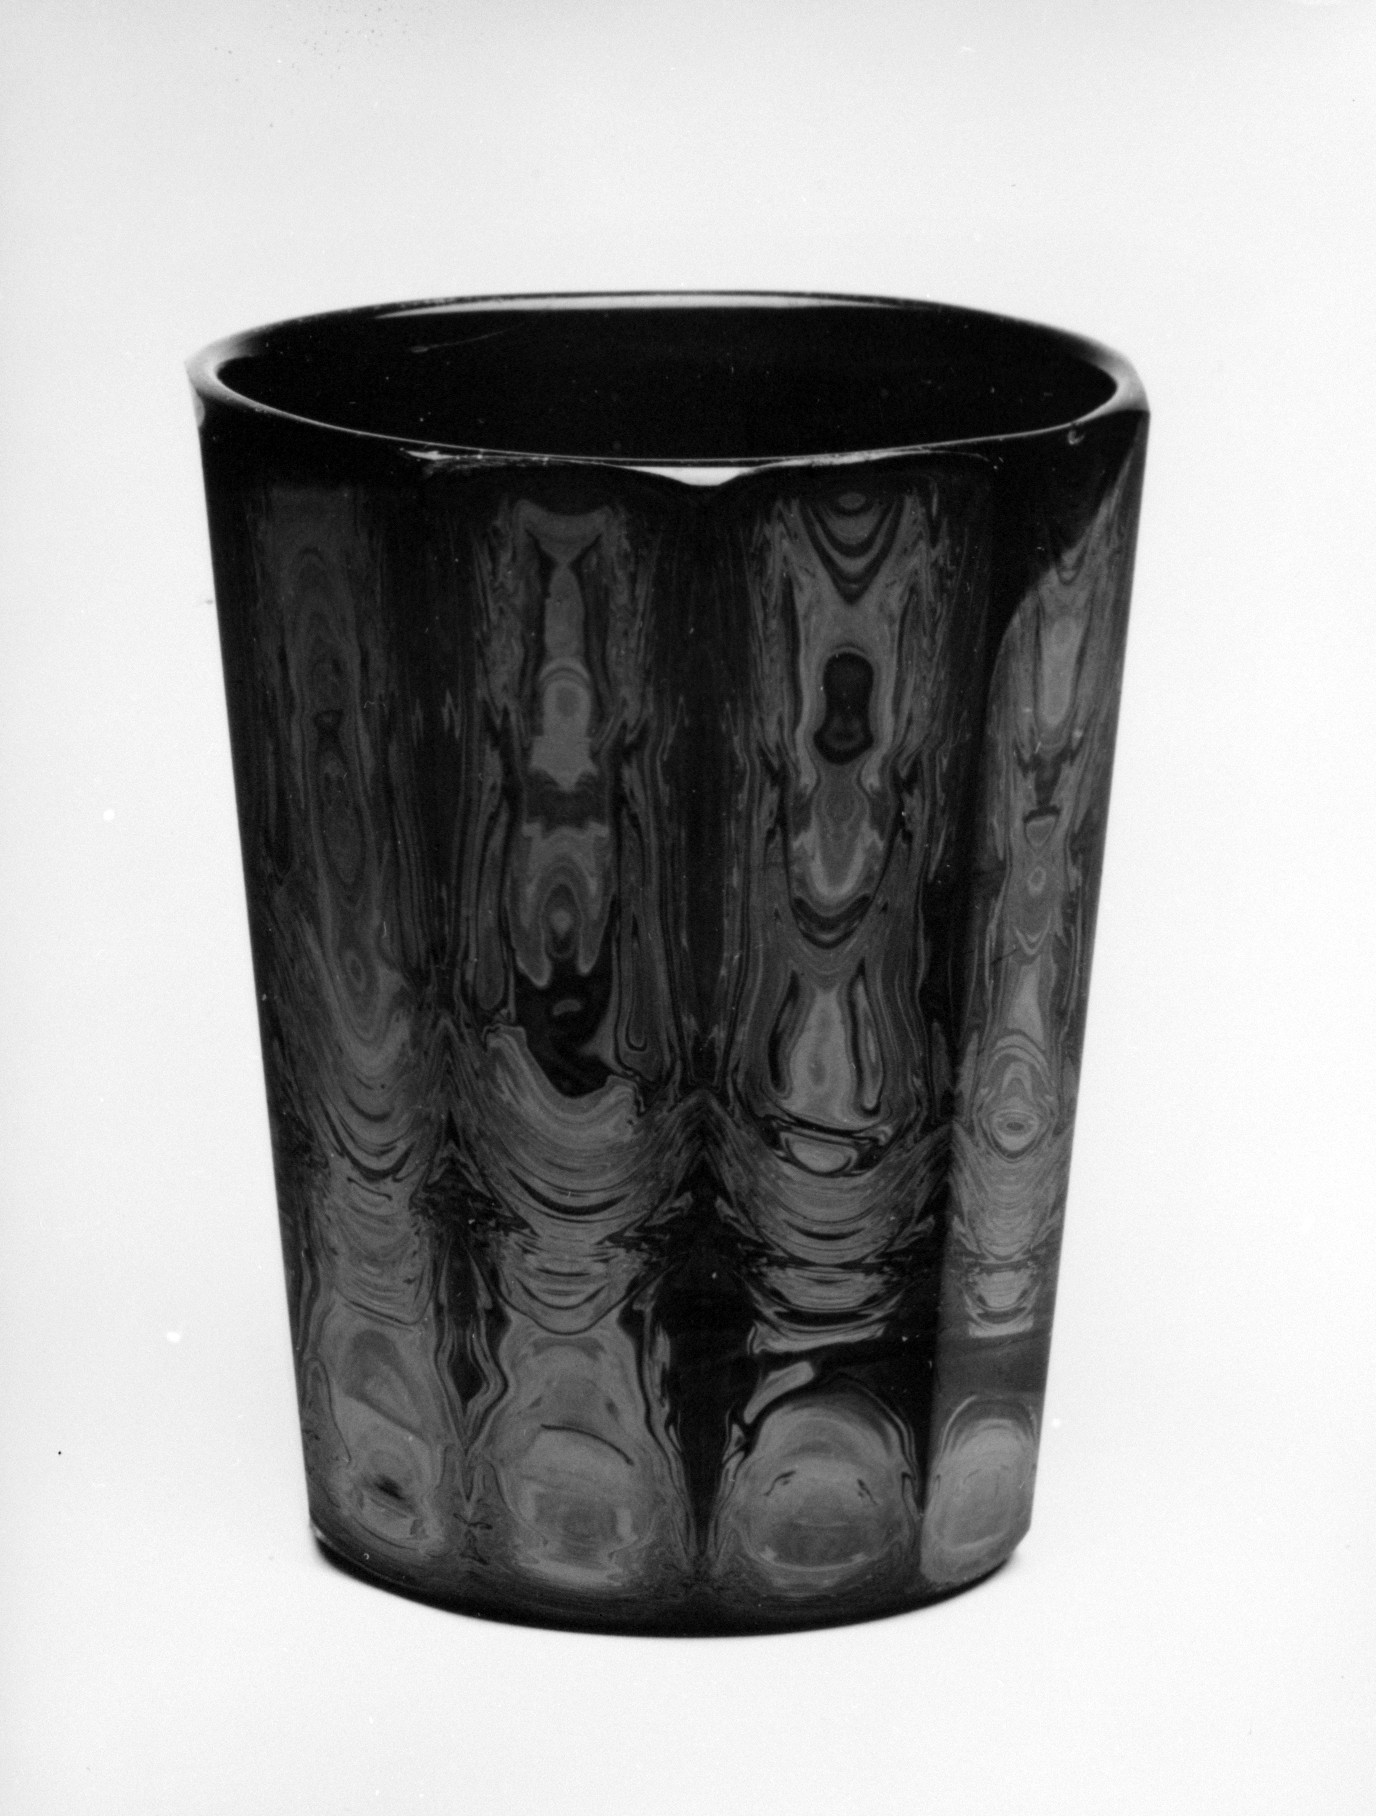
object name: beaker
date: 1820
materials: glass